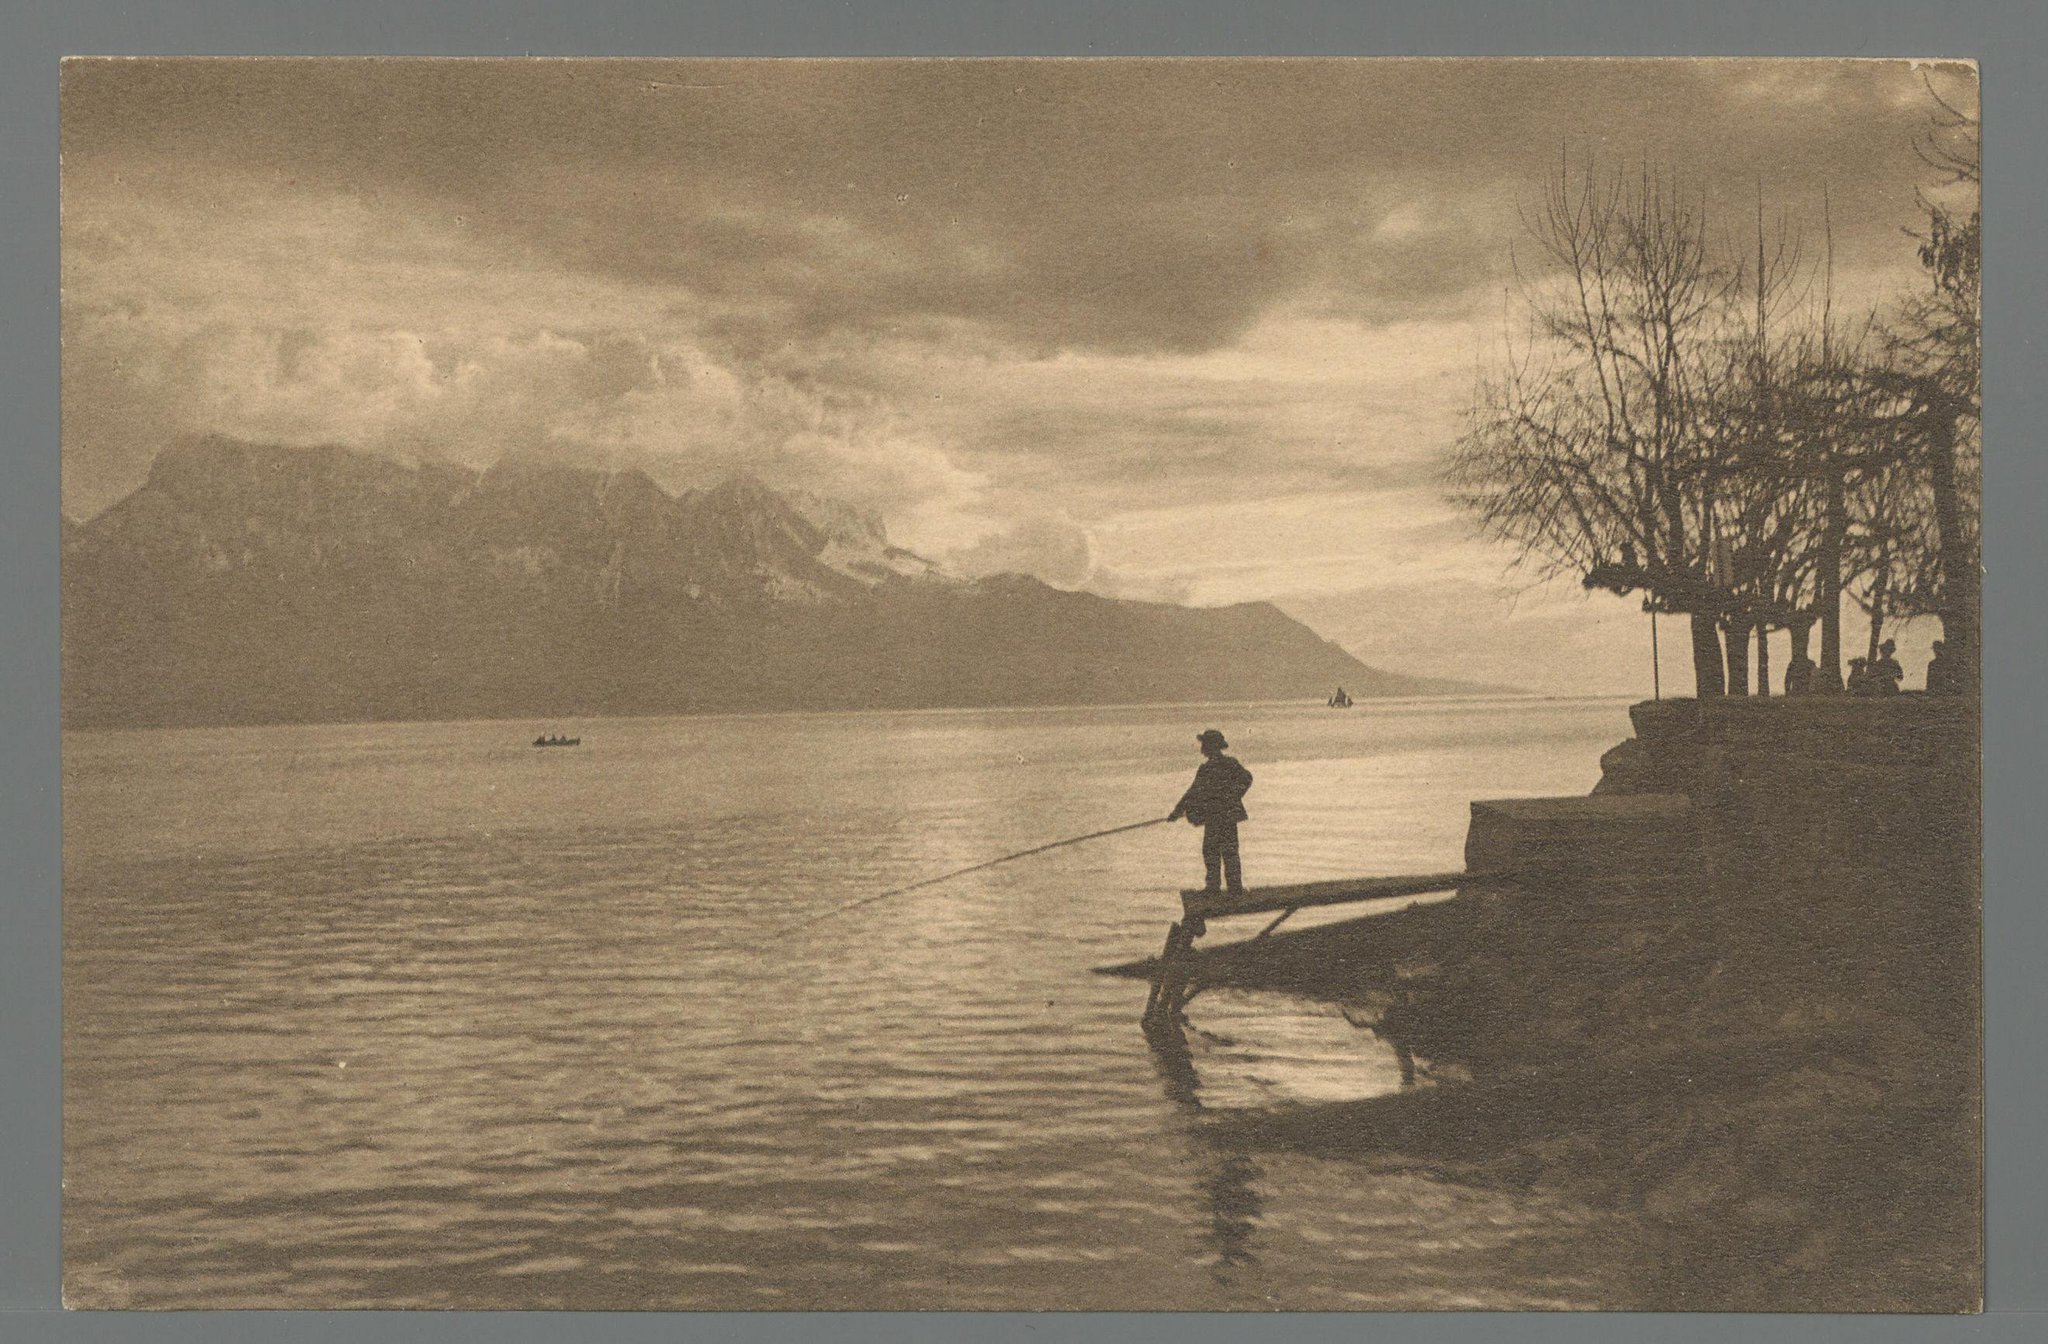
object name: ansichtkaart, prentbriefkaart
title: Visser aan het Meer van Genève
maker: Anonymous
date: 1905-1909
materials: cardboard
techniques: photograph, writing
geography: lake geneva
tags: lake, mountain-range, snow peaks, fisherman